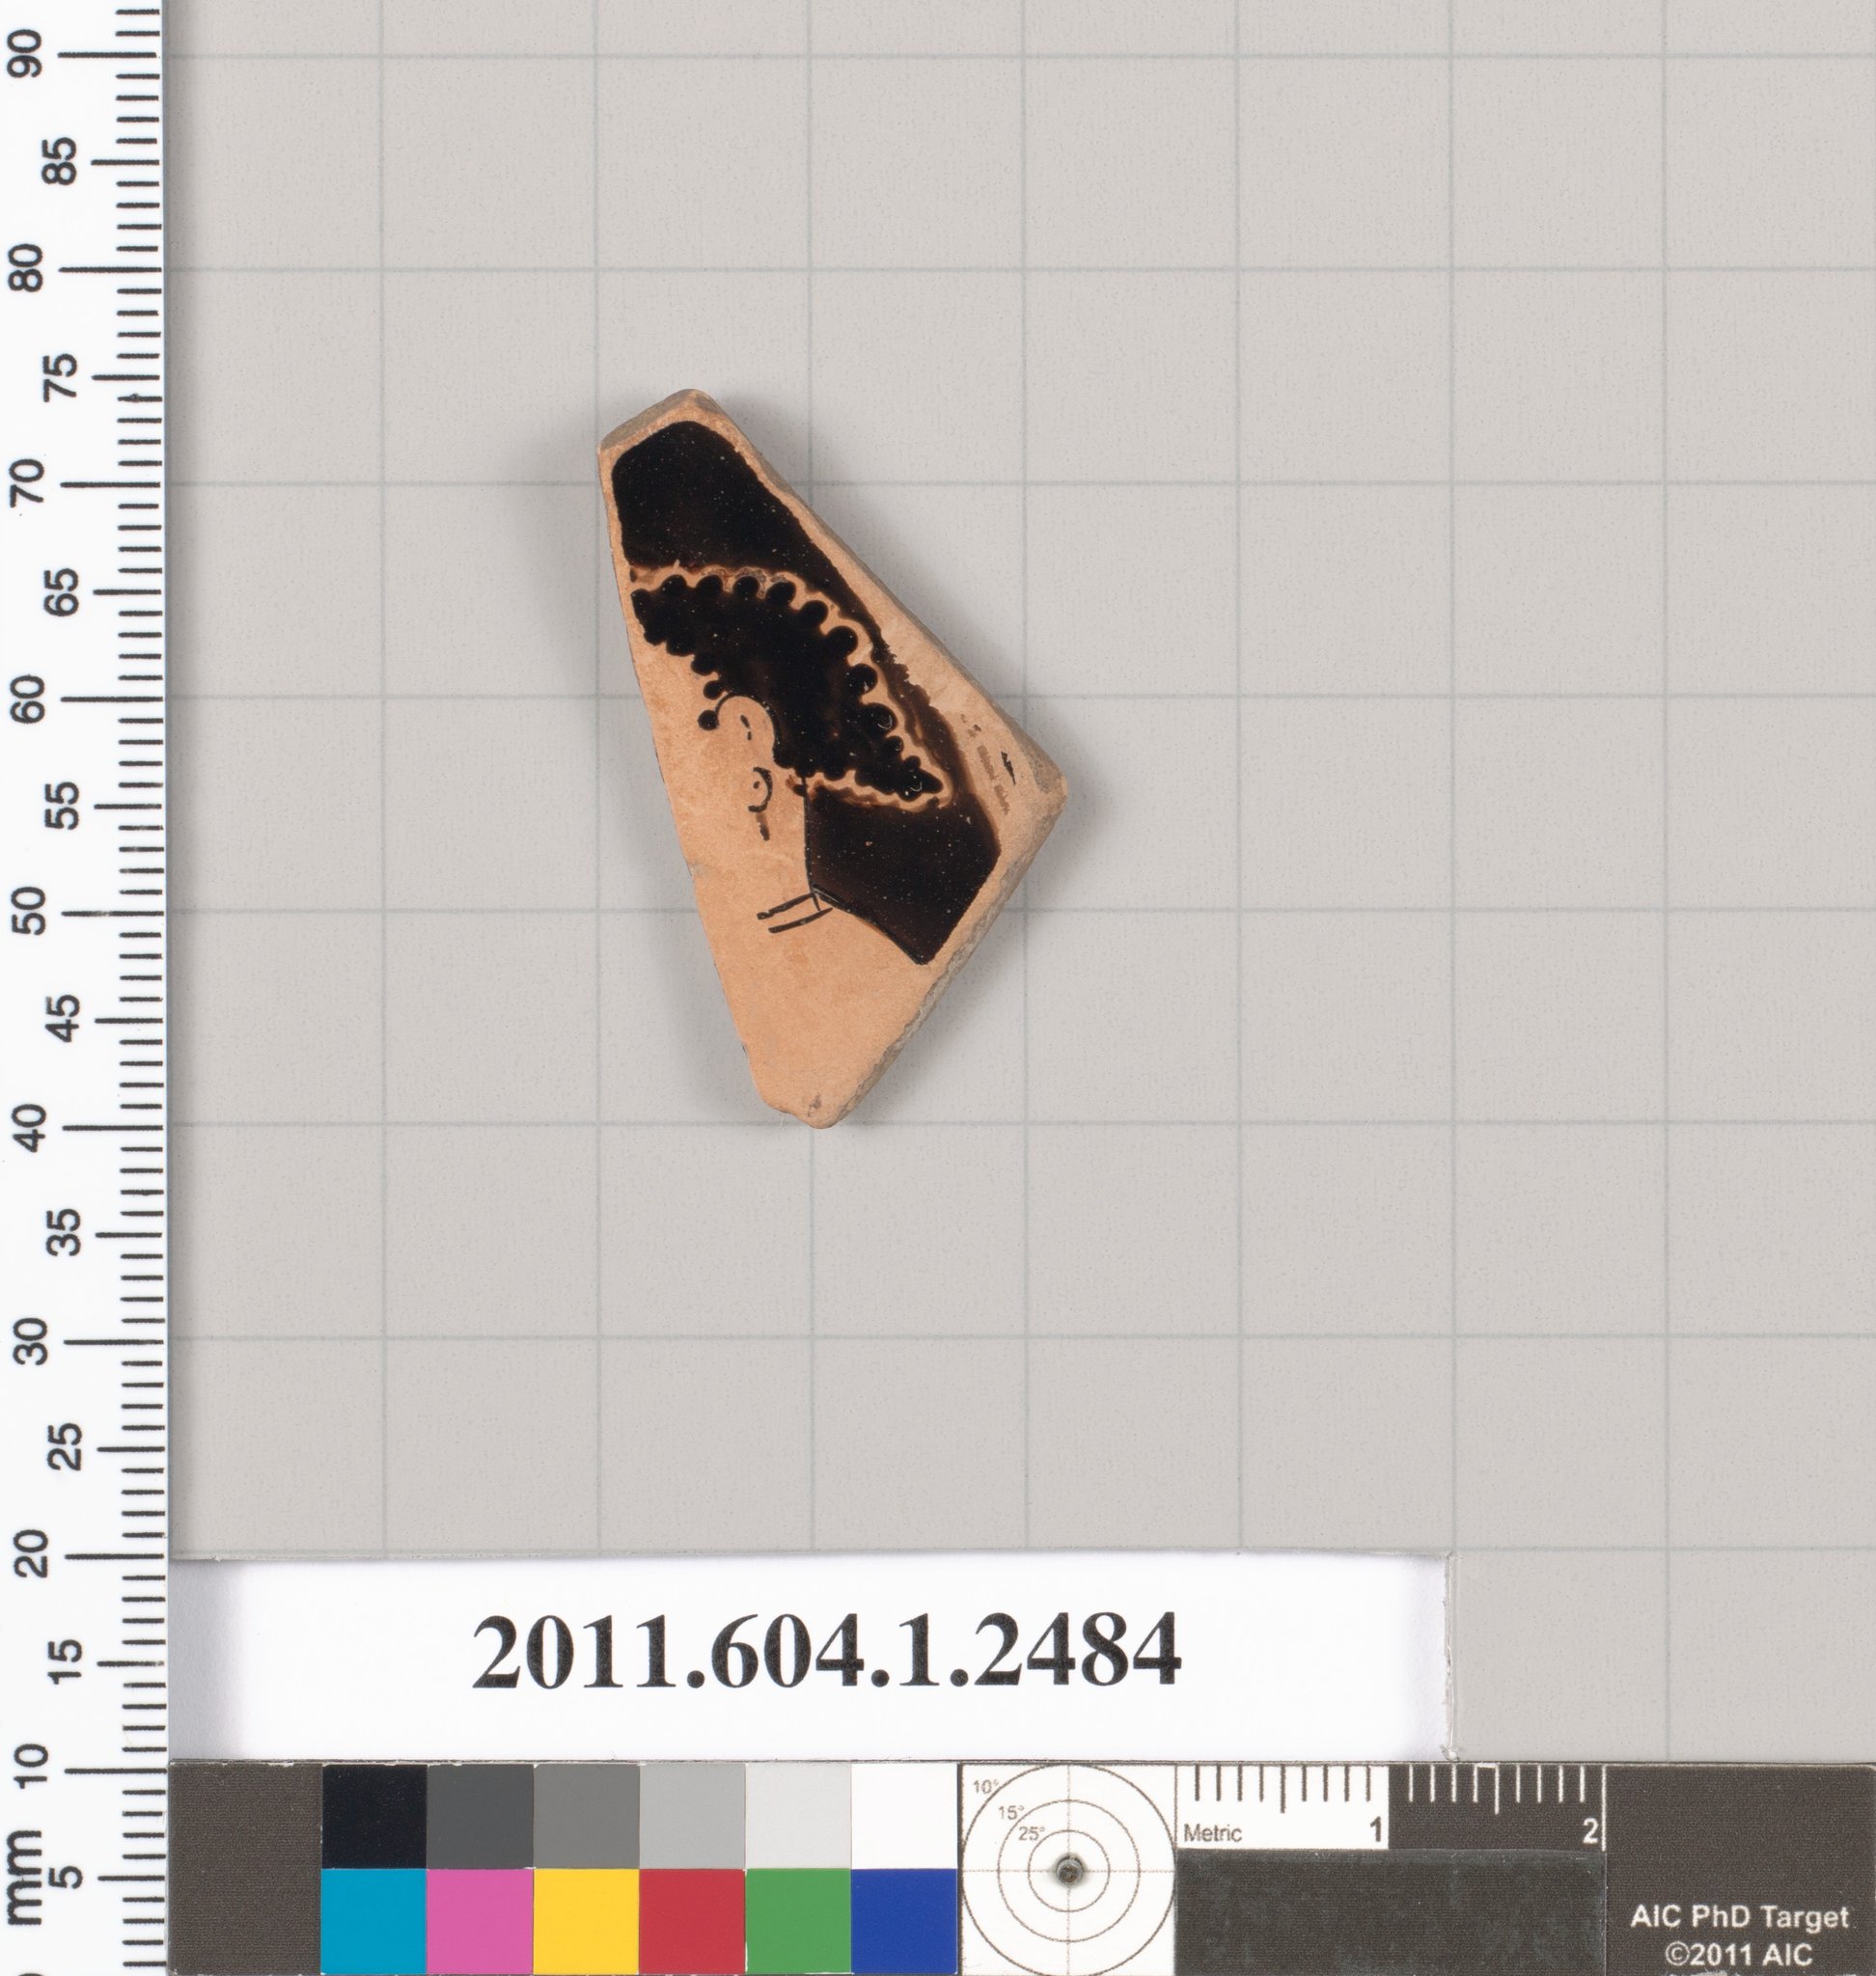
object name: kylix fragment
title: Terracotta fragment of a kylix (drinking cup)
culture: greek, attic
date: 520-500 BCE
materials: terracotta